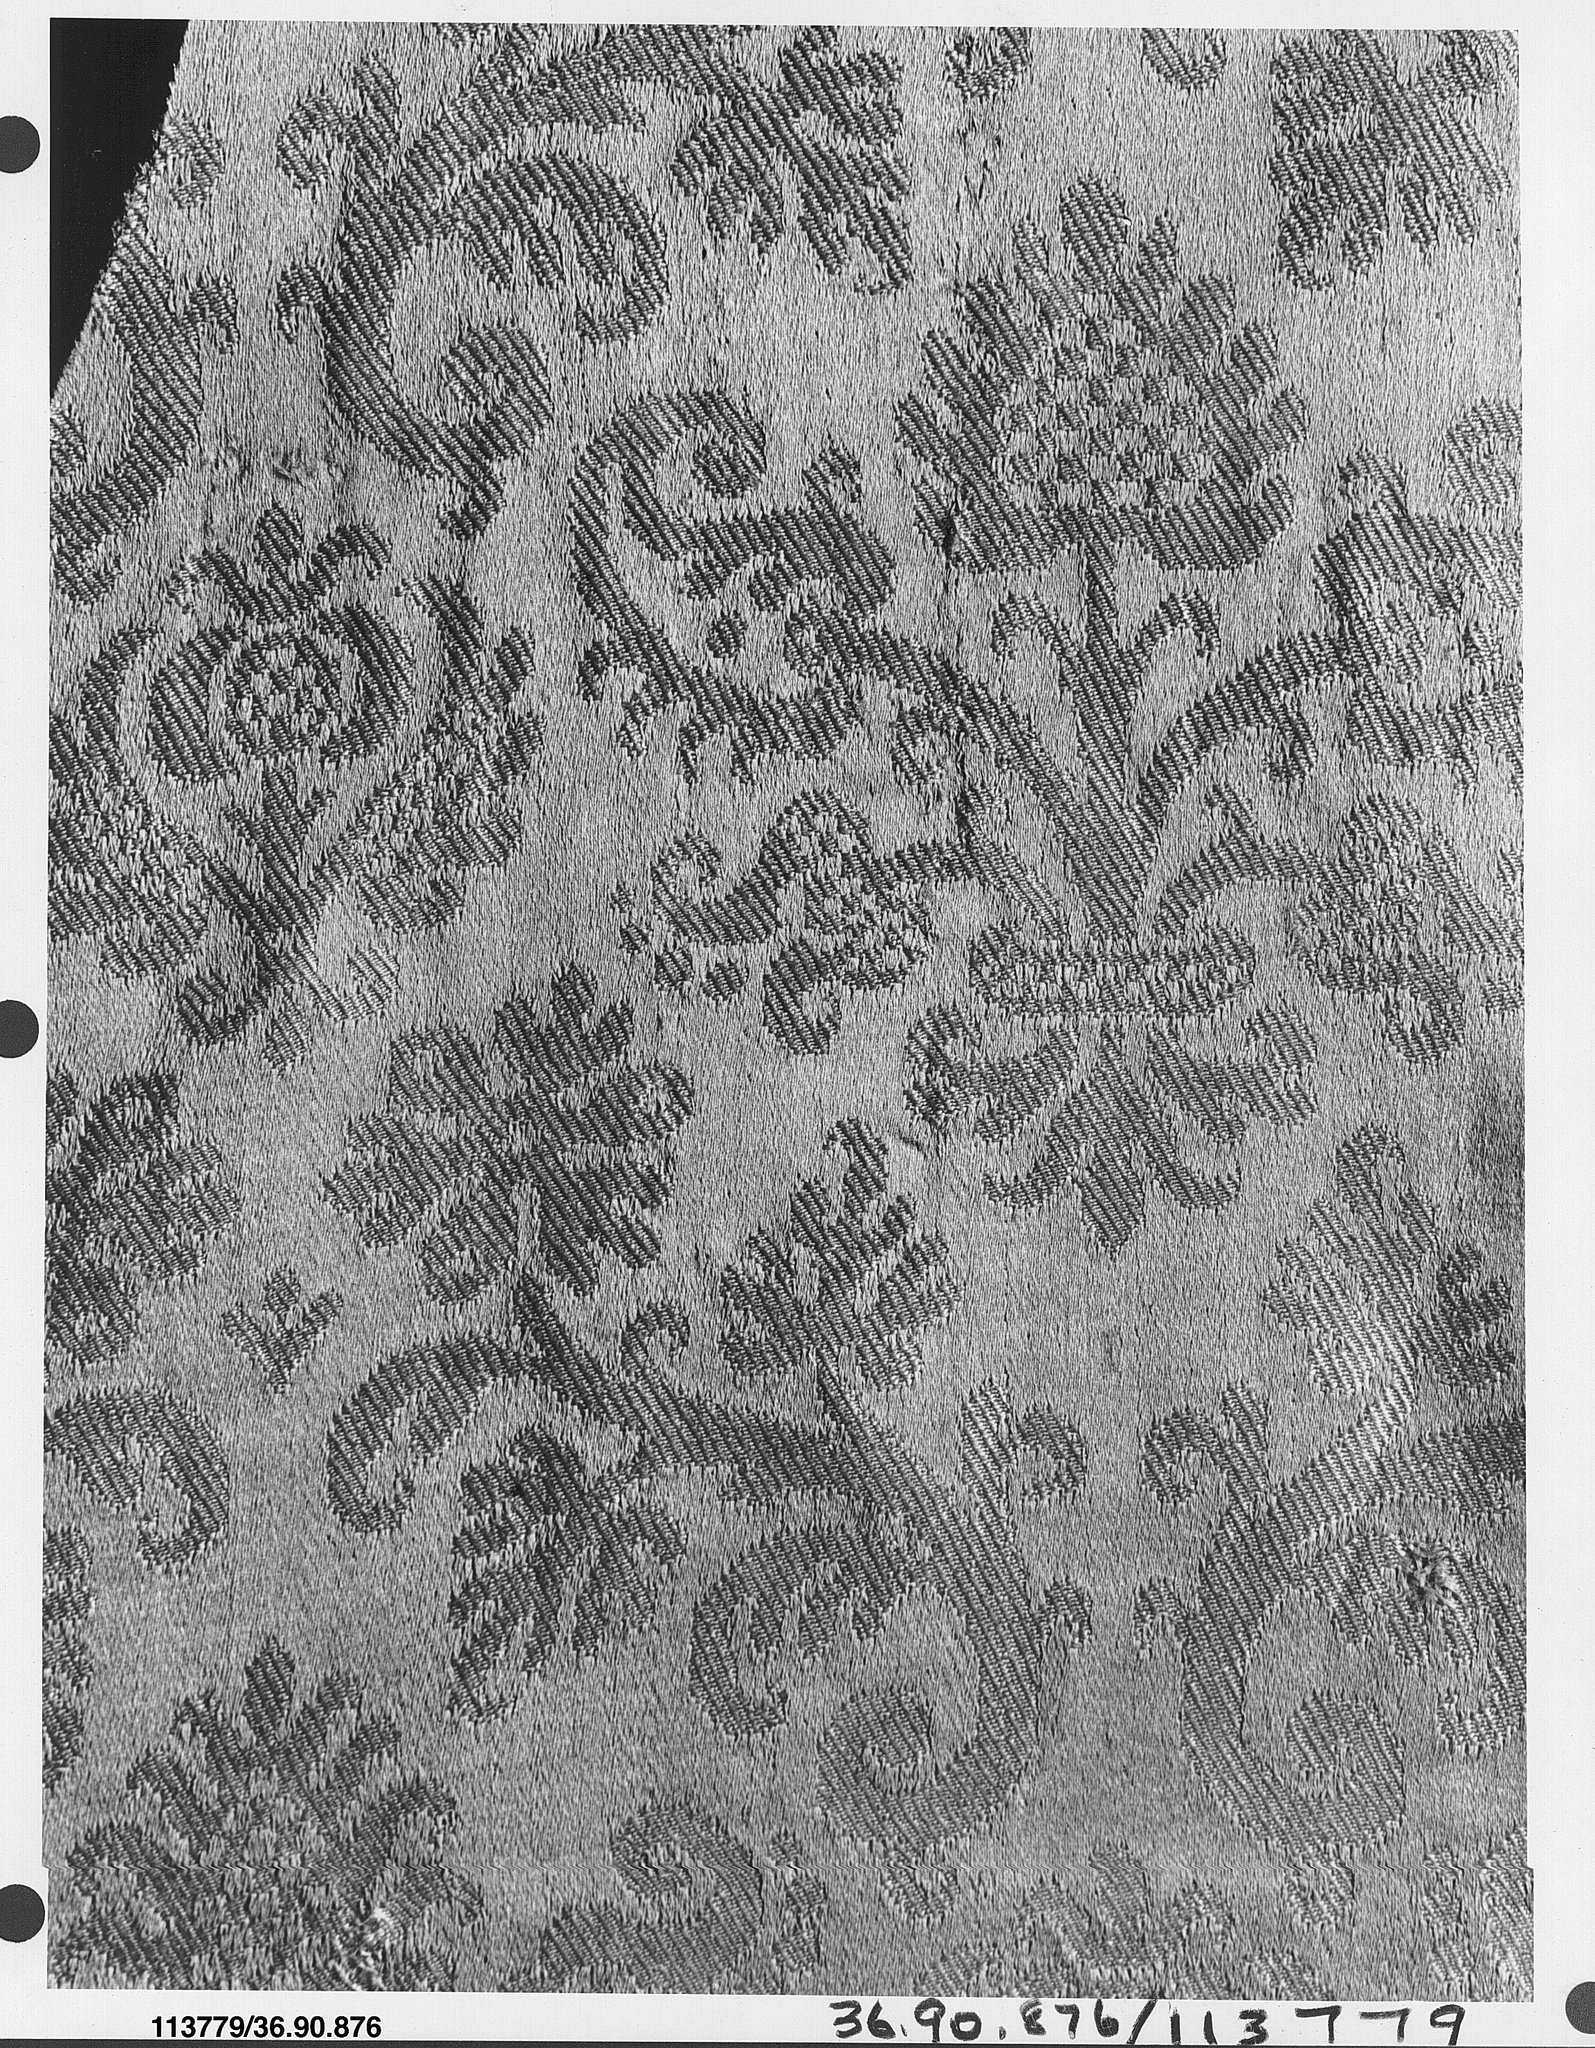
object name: piece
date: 1601-1700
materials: silk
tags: flowers